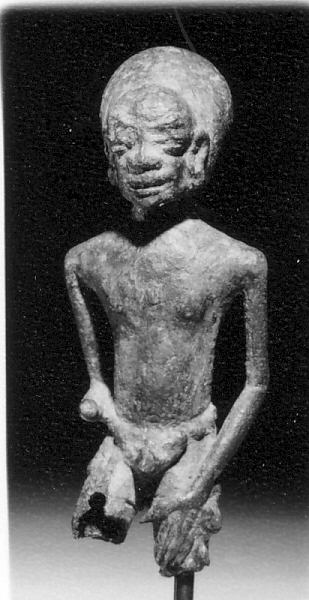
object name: figure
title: Standing Boy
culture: indonesian, javanese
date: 1101-1400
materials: bronze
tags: boys